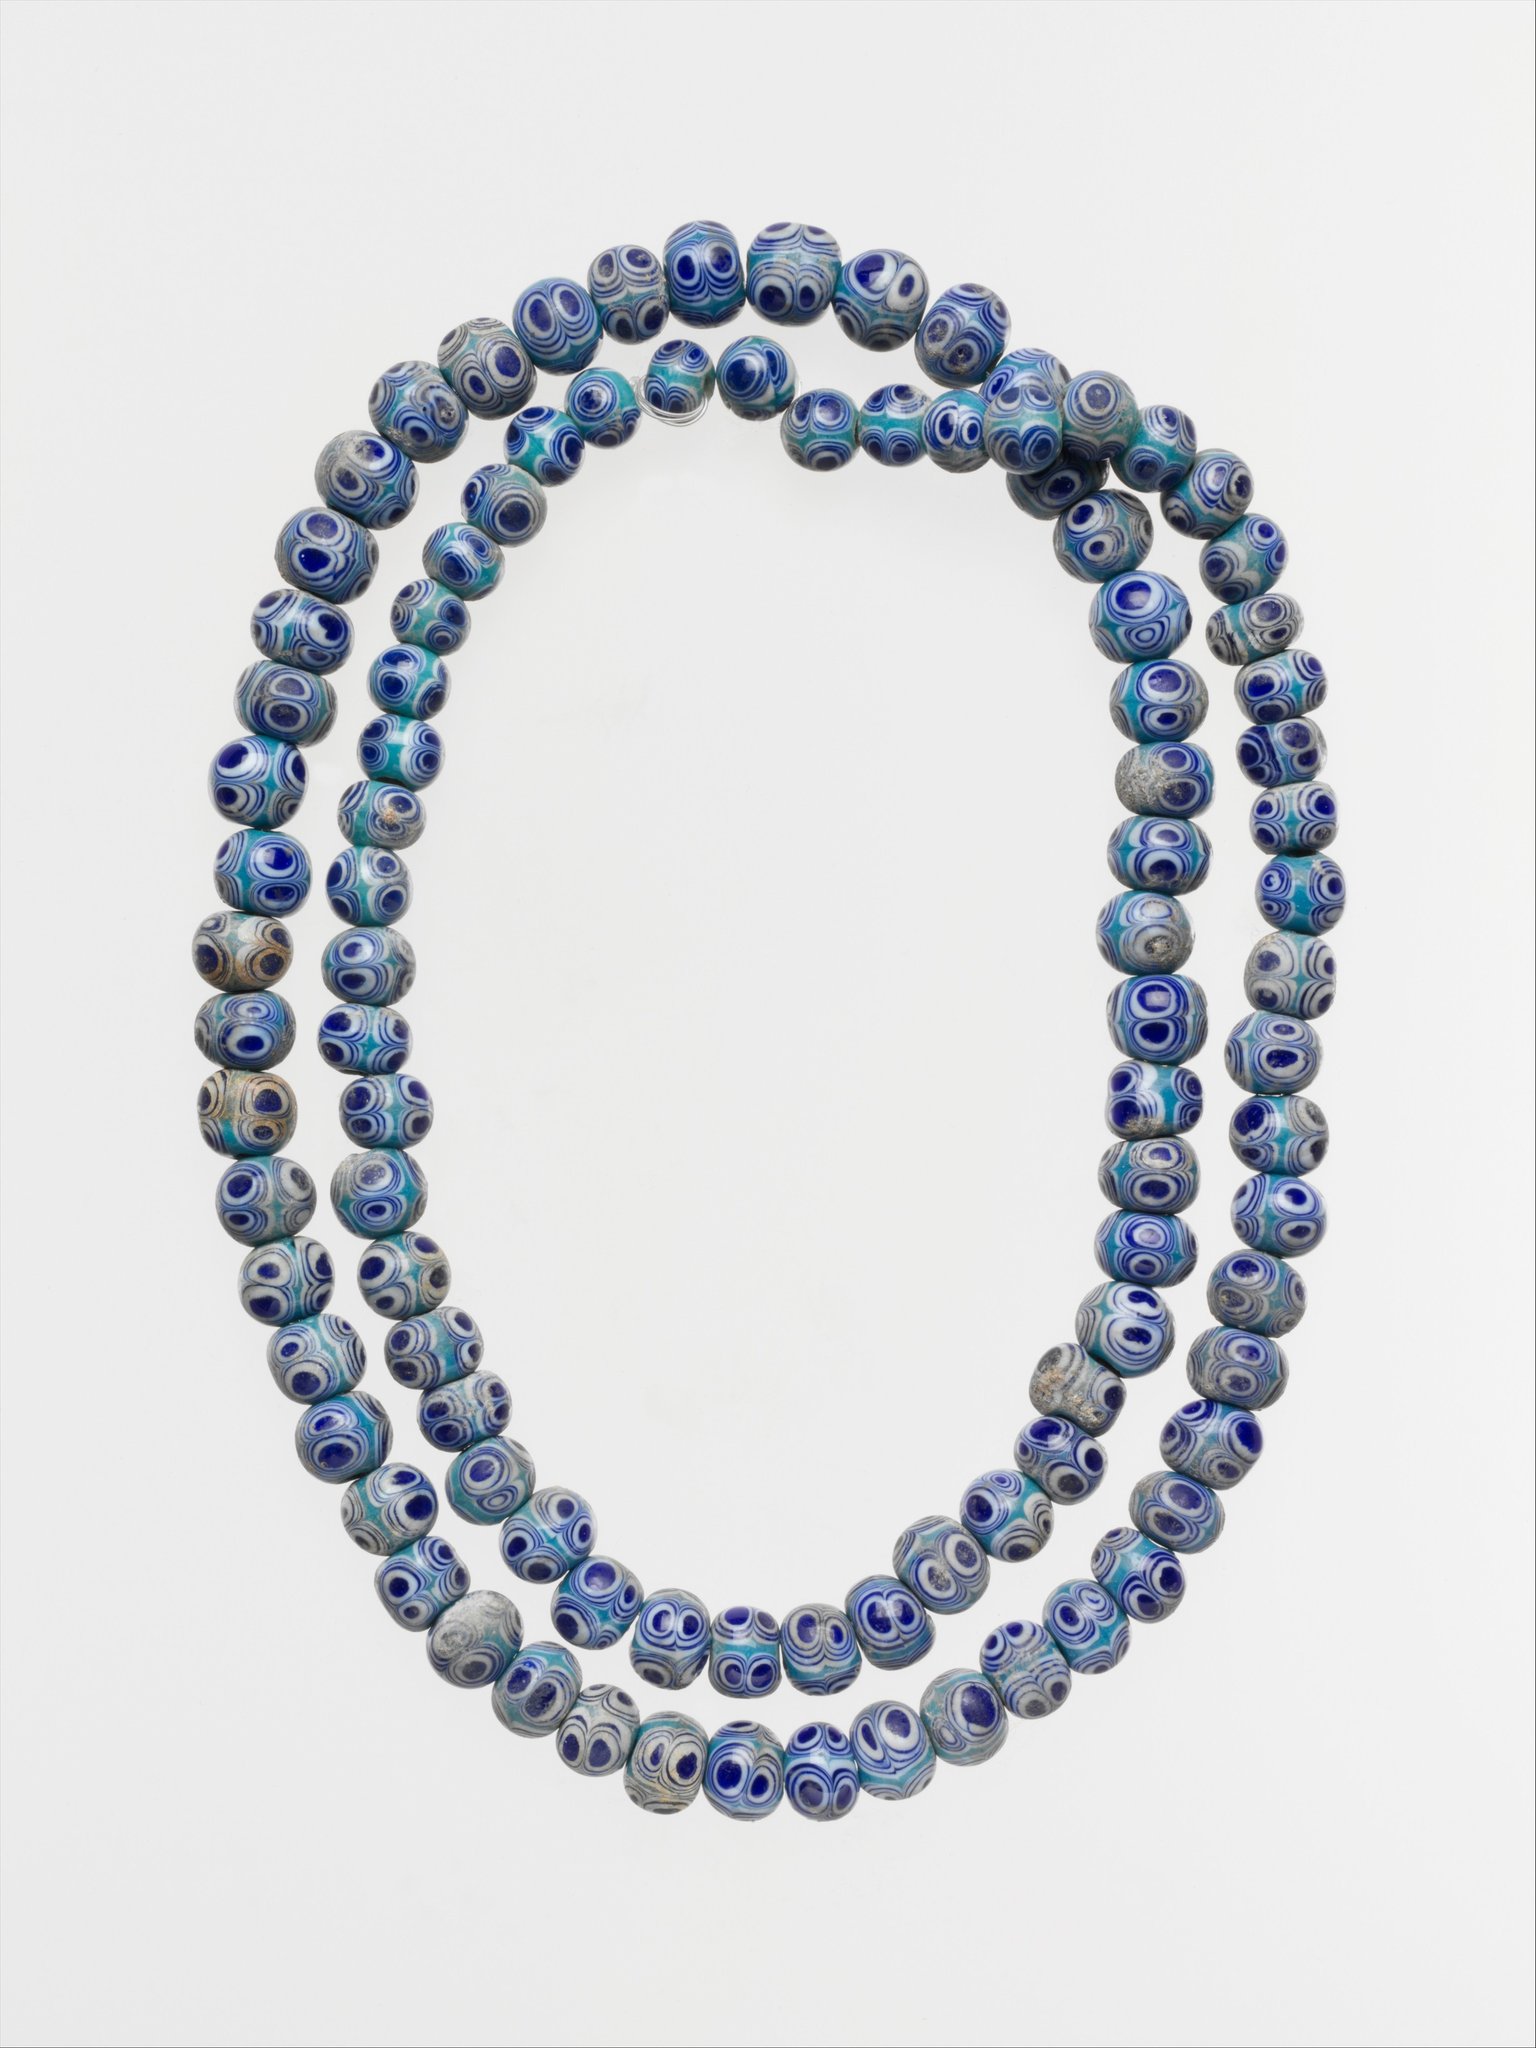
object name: bead, 97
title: String of ninety-seven glass eye beads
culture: greek, eastern mediterranean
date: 600-301 BCE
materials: glass